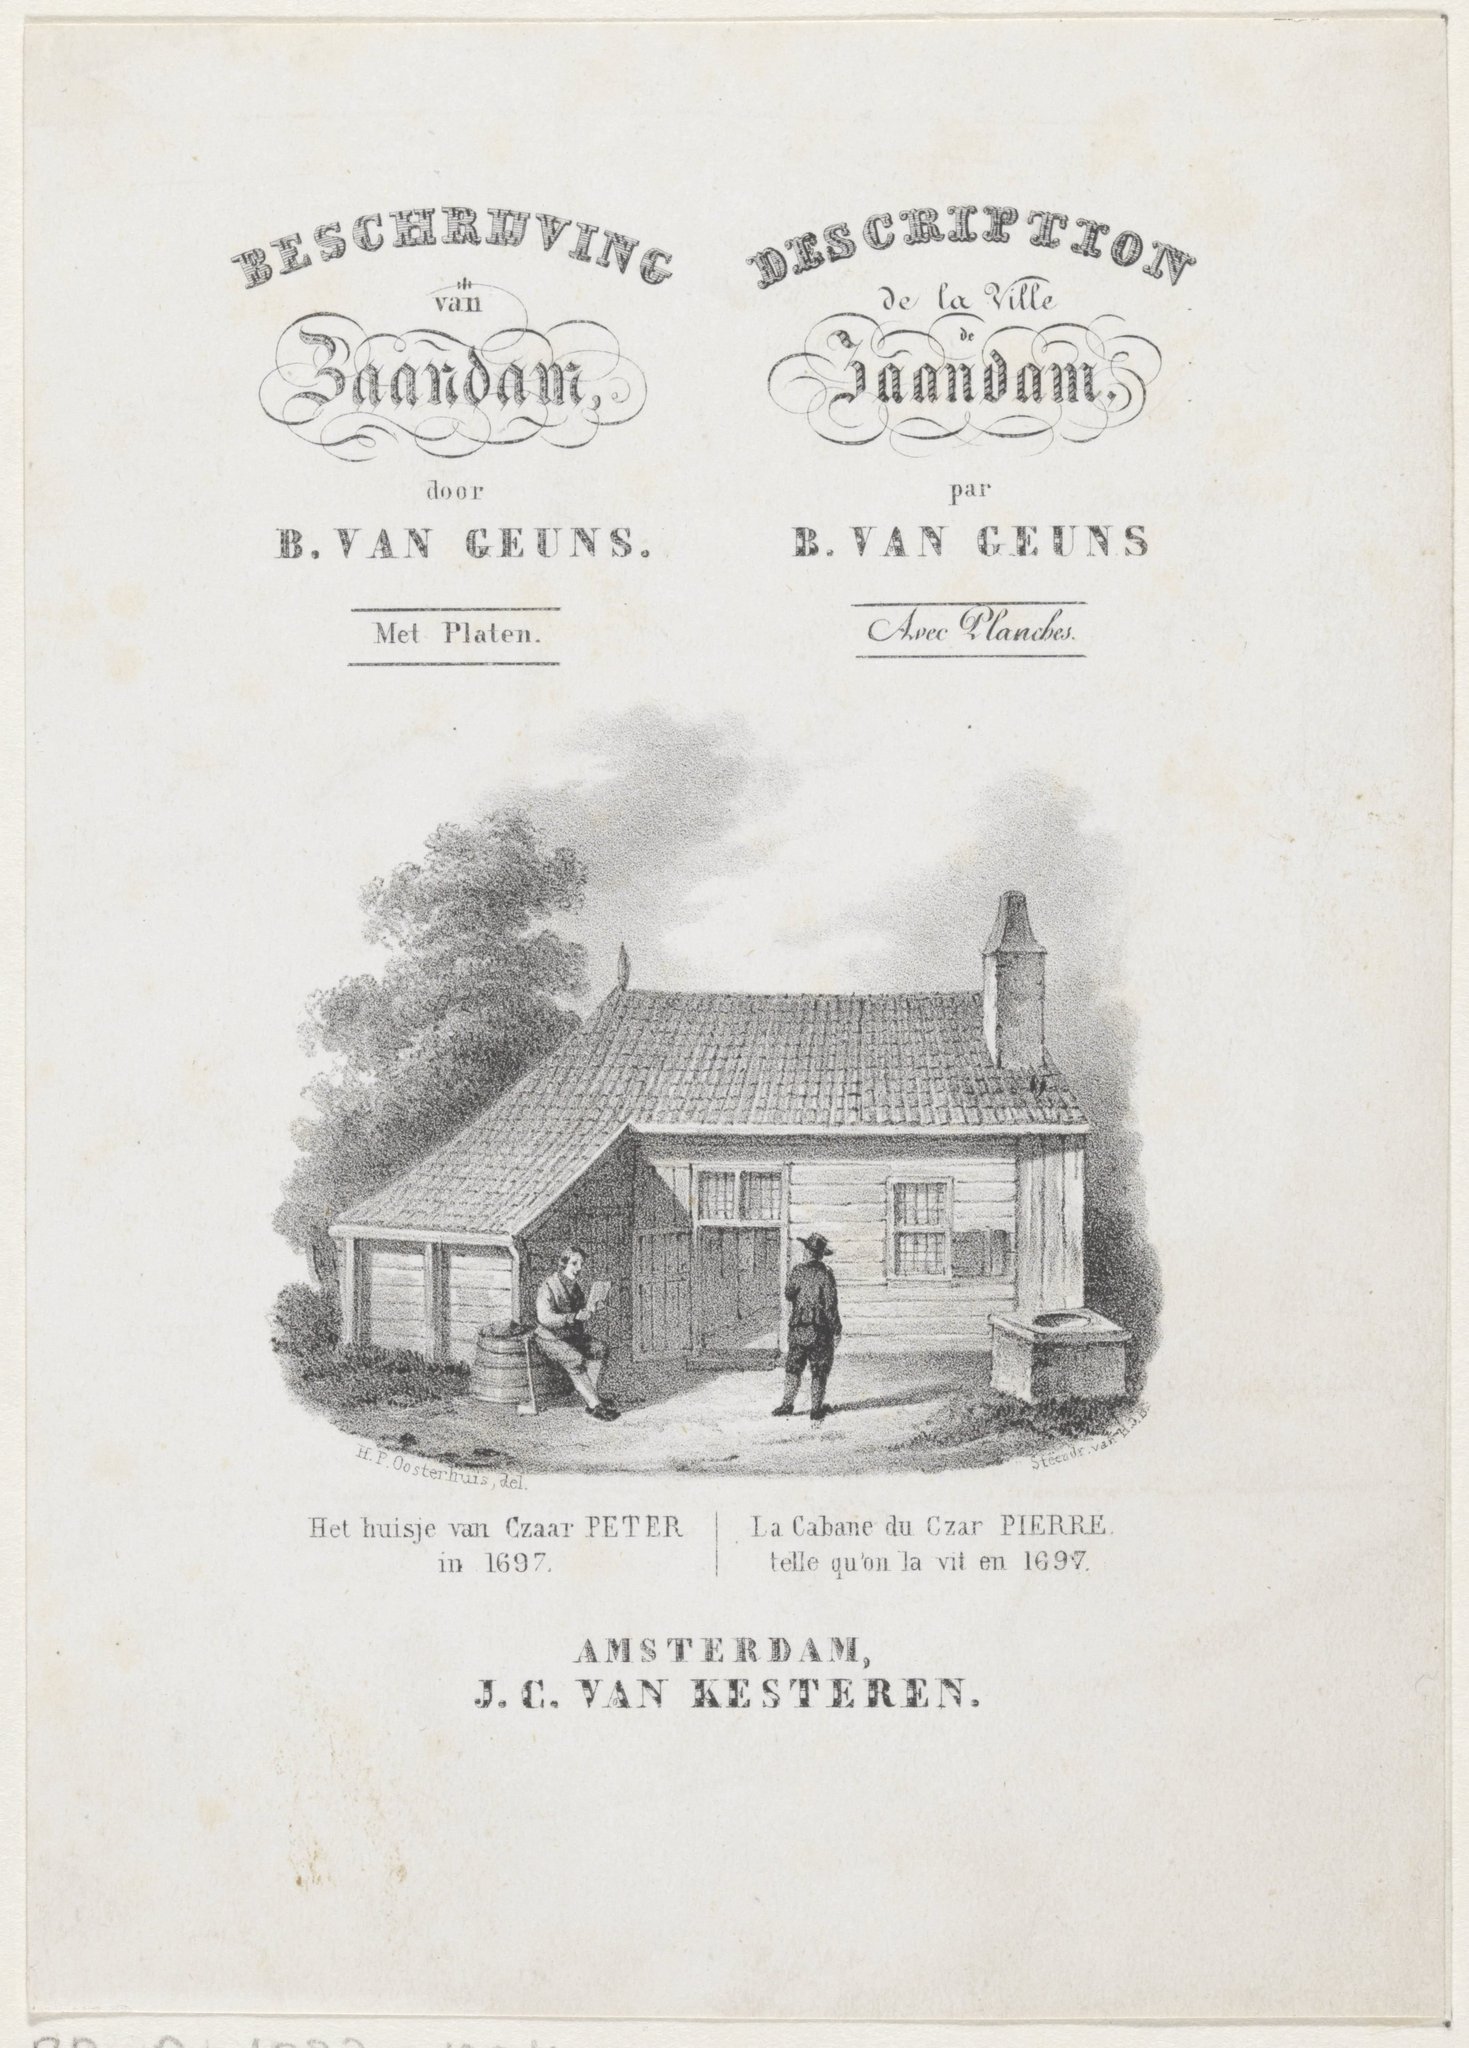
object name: print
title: Het Tsaar Peterhuisje met figuren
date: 1842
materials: paper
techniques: lithograph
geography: dordrecht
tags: peter i de grote (tsaar van rusland), rural housing, e.g. country-house, villa, cottage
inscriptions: collector's mark: Lugt 2228, collector's mark: Lugt 2760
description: De deur van het huisje staat open. Ervoor zit een lezende man. Naast hem staat een bijl. Voor het huisje staat een man op de rug gezien.